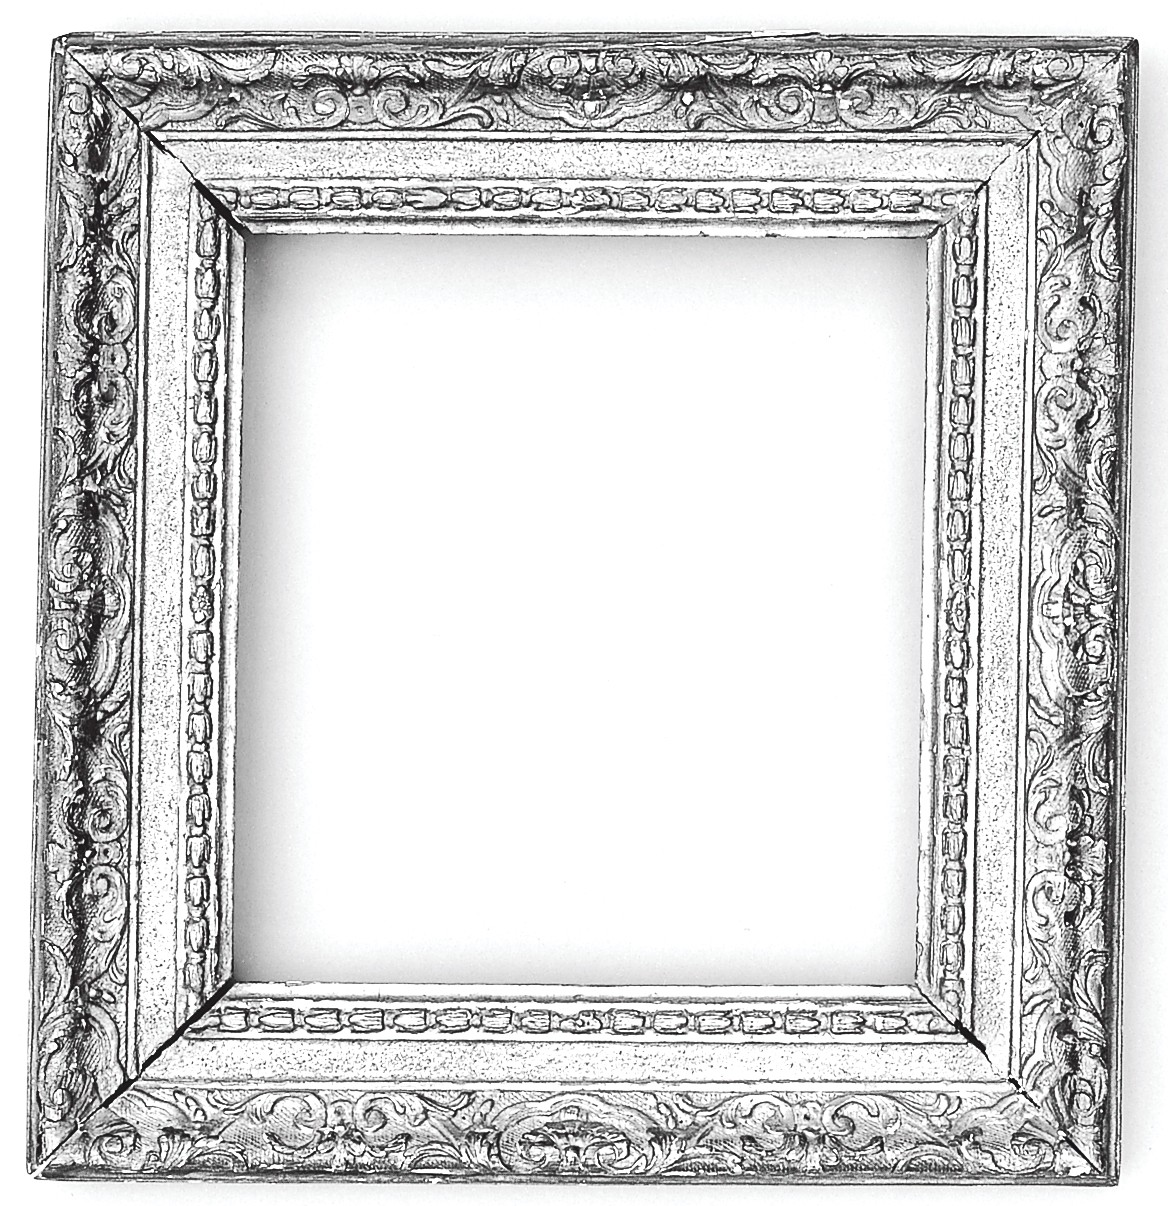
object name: frame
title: Ogee frame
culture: french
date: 1700-1710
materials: wood